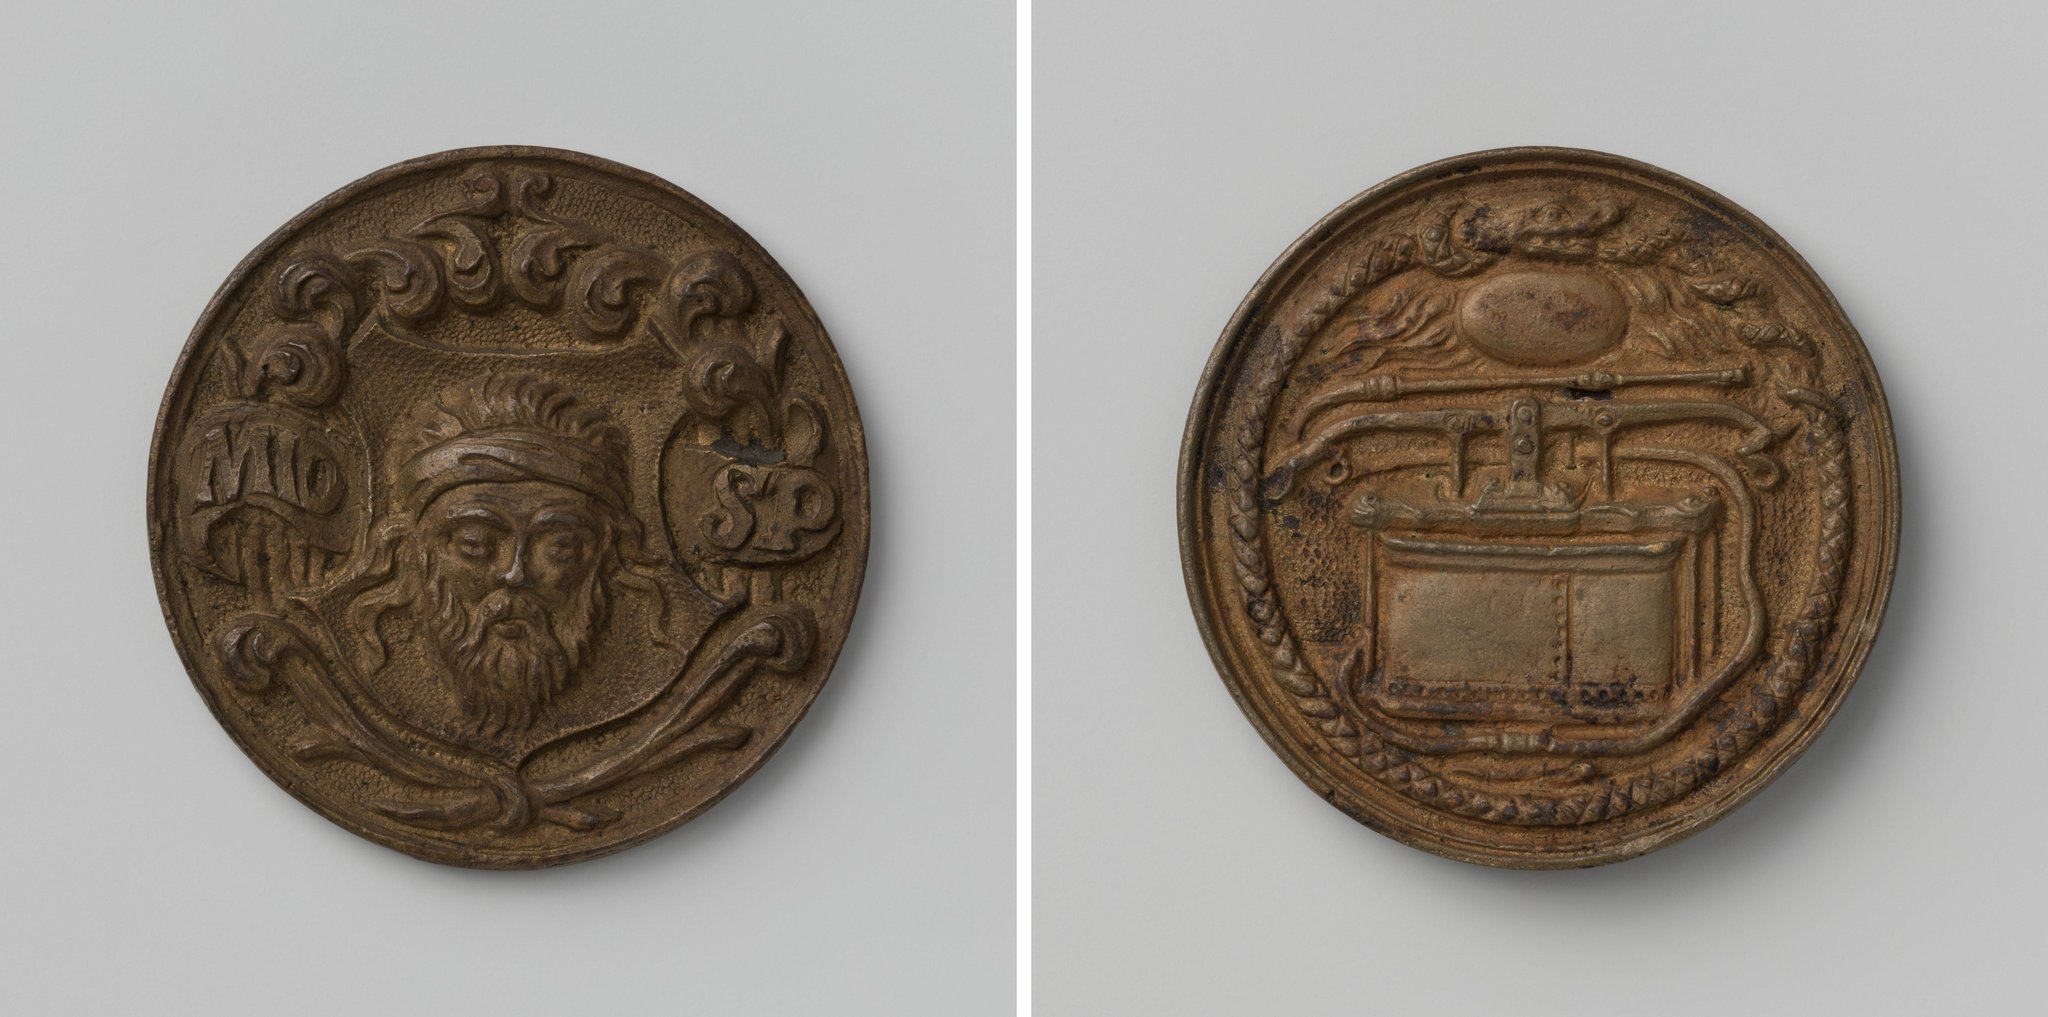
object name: fire engine medal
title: Wormer, brandspuitpenning van de Middenspuit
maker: Anonymous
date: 1680-1800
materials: brass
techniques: casting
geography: wormer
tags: wormer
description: Messing penning. Voorzijde: bebaard mannenhoofd in cartouche omgeven door versierd loofwerk; daarachter: lint met opschrift. Keerzijde: brandspuit onder leeg cartouche binnen slangerond